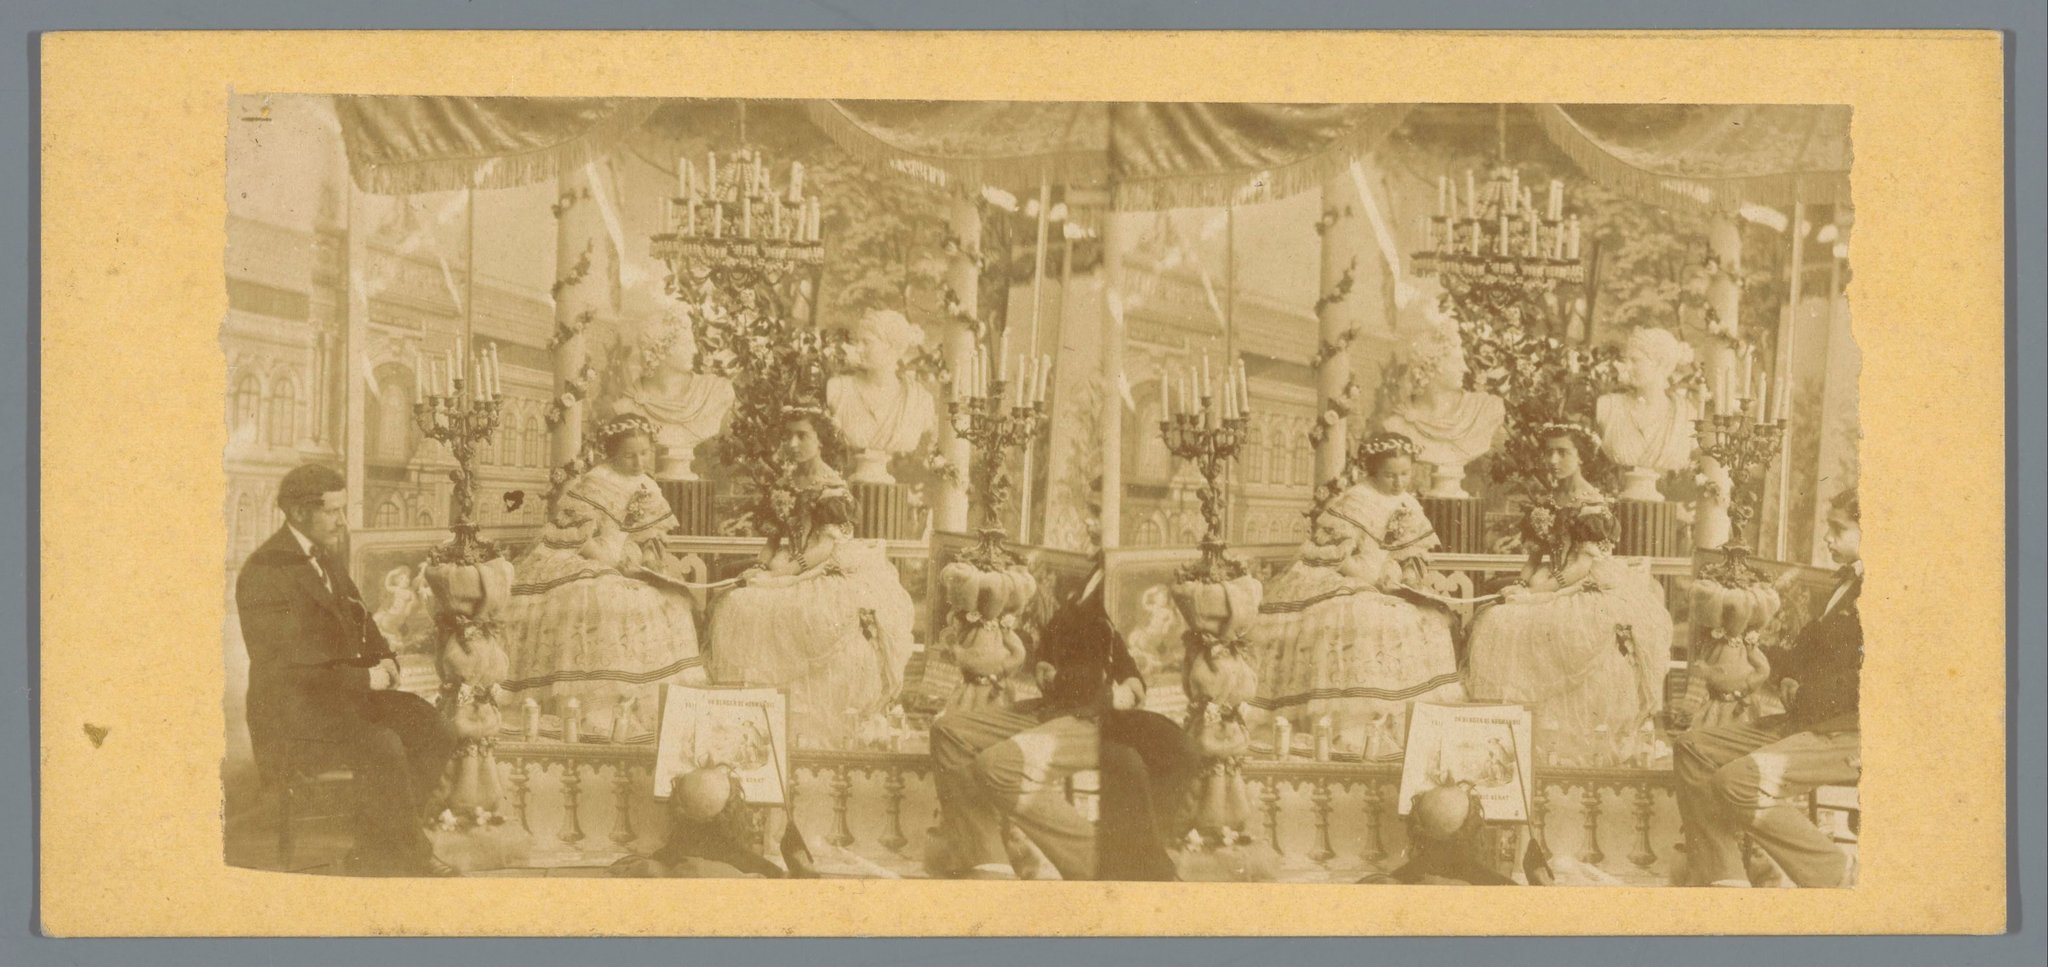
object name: stereograph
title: Twee vrouwen met op de voorgrond een dirigent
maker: Anonymous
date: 1850-1880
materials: cardboard, photographic support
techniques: albumen print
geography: europe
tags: vocal music, singing, conductor ~ music, europe